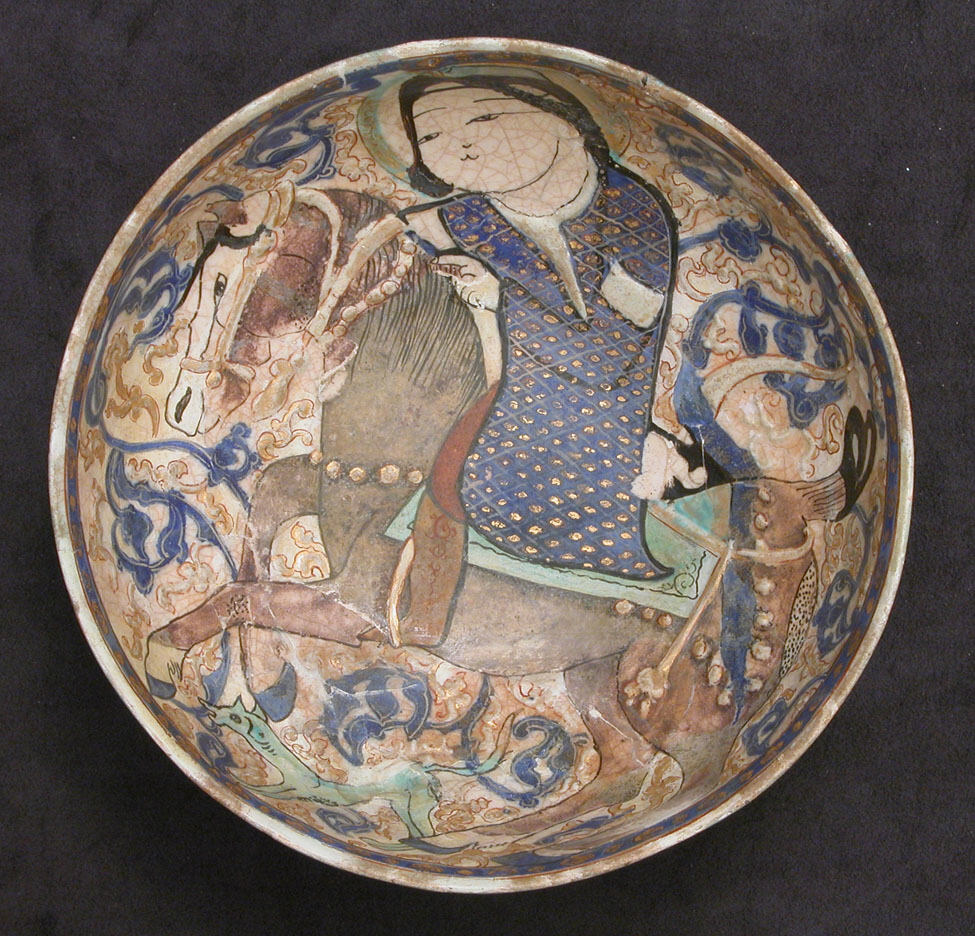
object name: bowl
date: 1101-1300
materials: glaze, stonepaste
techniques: gilding, overglaze, painting, polychrome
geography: iran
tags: human figures,horses